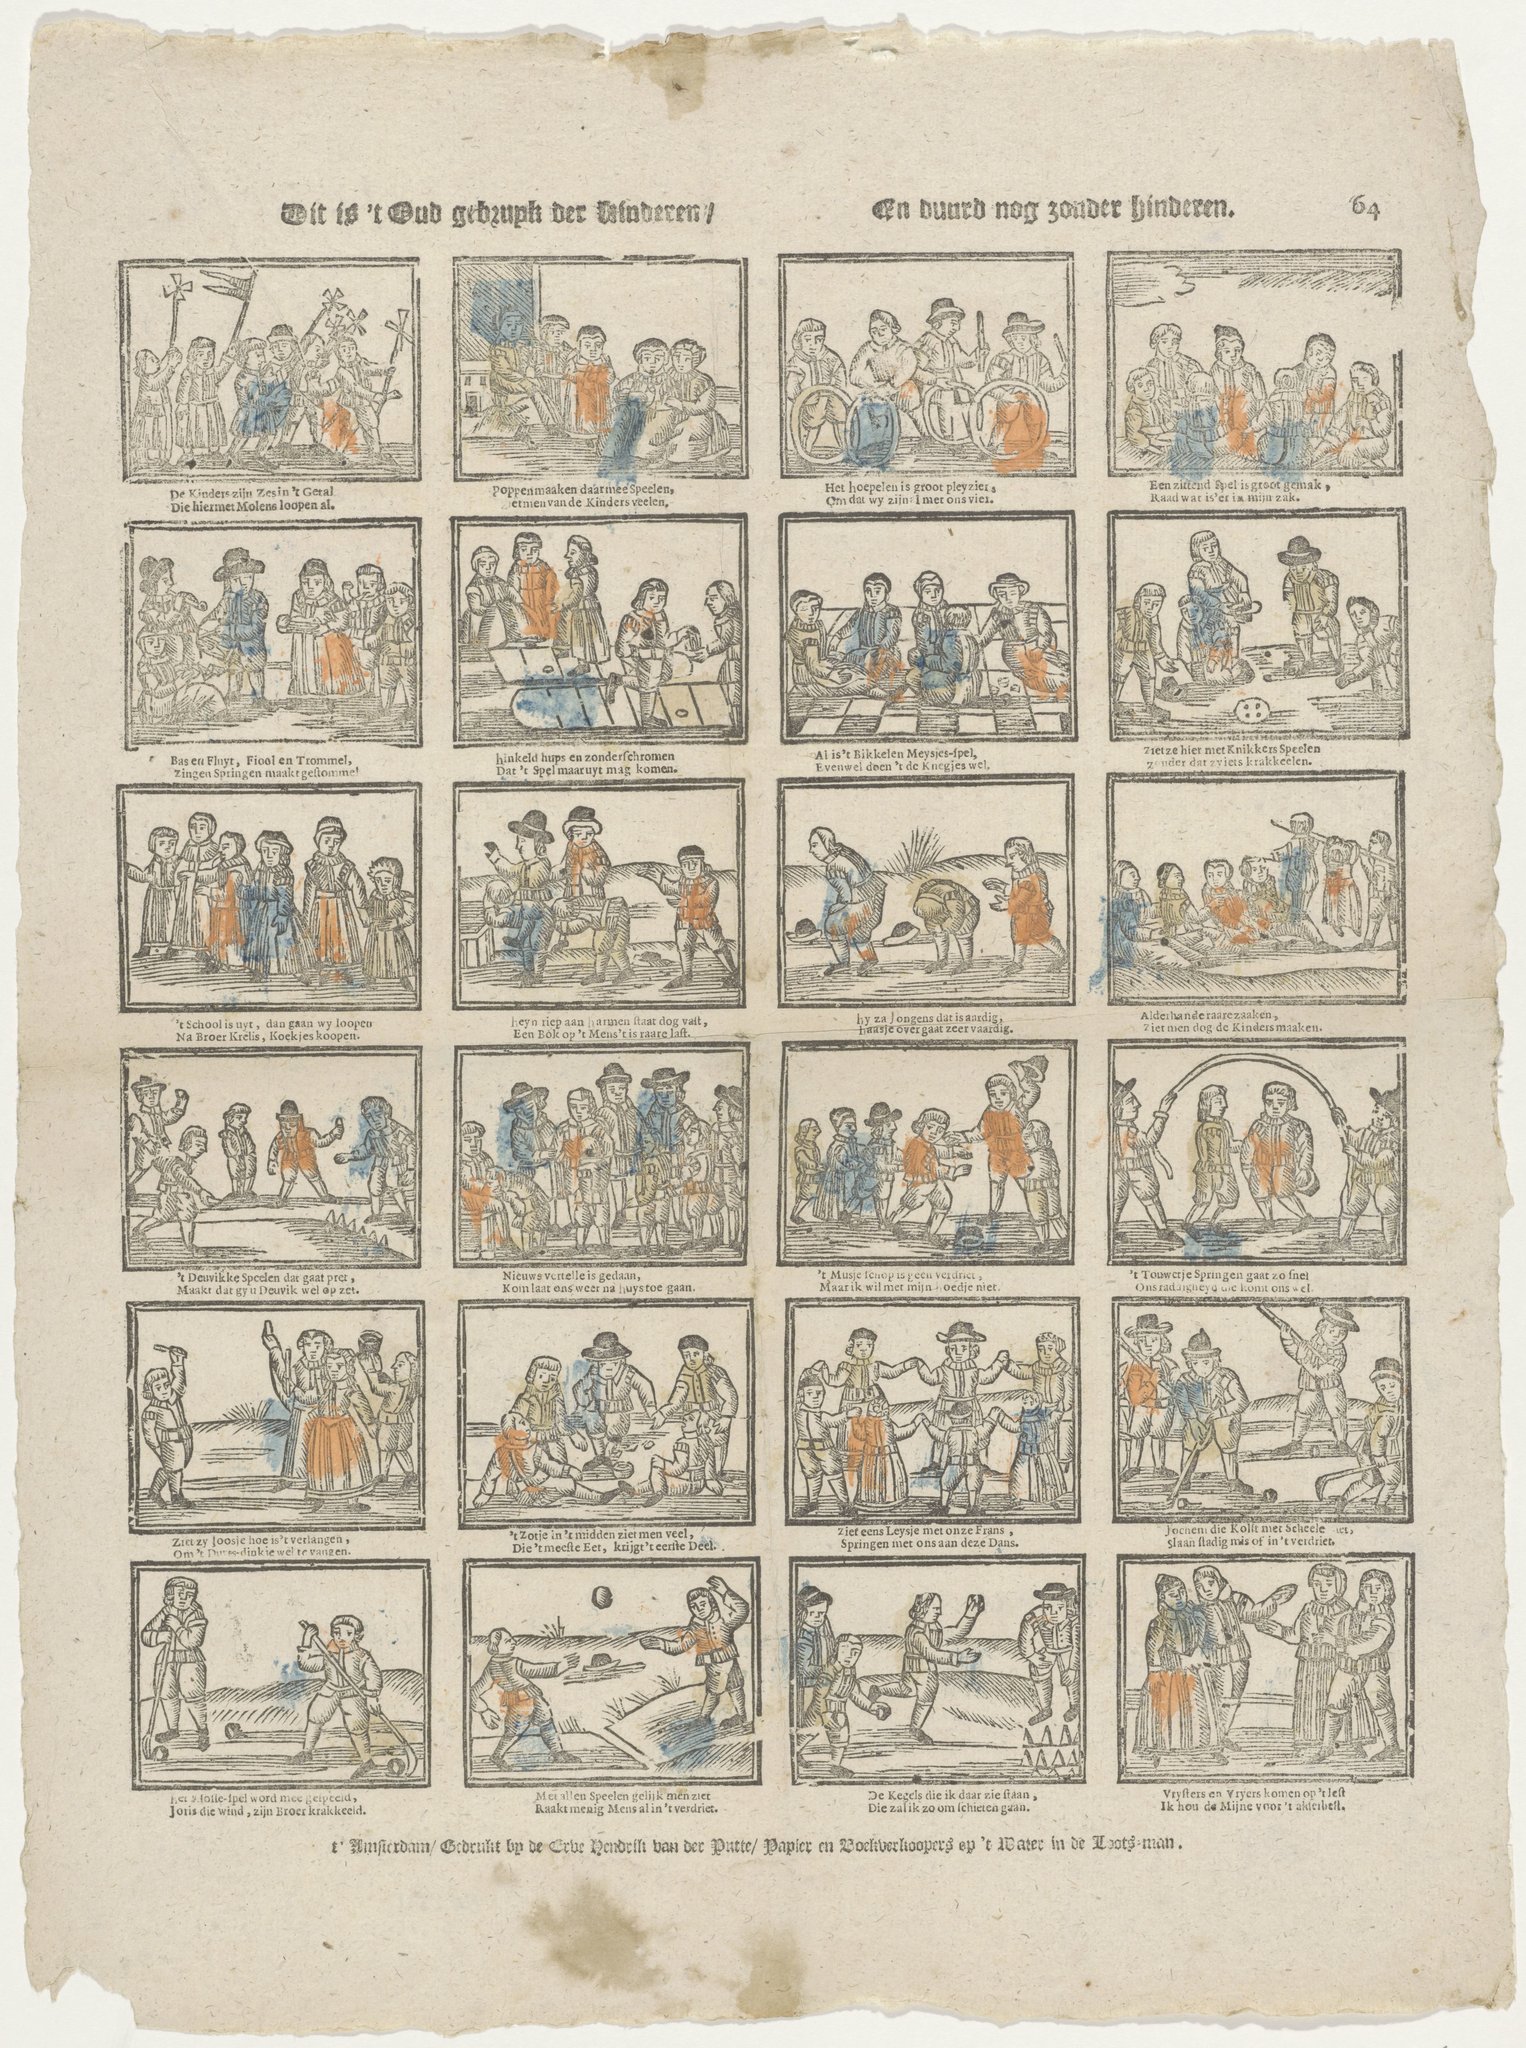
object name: popular print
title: Dit is 't oud gebruyk der kinderen / En duurd nog zonder hinderen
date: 1770-1794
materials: paper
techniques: colour, letterpress printing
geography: amsterdam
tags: children's games and plays, dancing, games using special objects (marbles, top, hoop, etc.), jumping-rope games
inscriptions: collector's mark: Lugt 2760, collector's mark: Lugt 2228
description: Blad met 24 voorstellingen van kinderspelen en bezigheden, zoals hoepelen, touwtjespringen en dansen. Onder elke afbeelding een tweeregelig vers. Genummerd rechtsboven: 64.